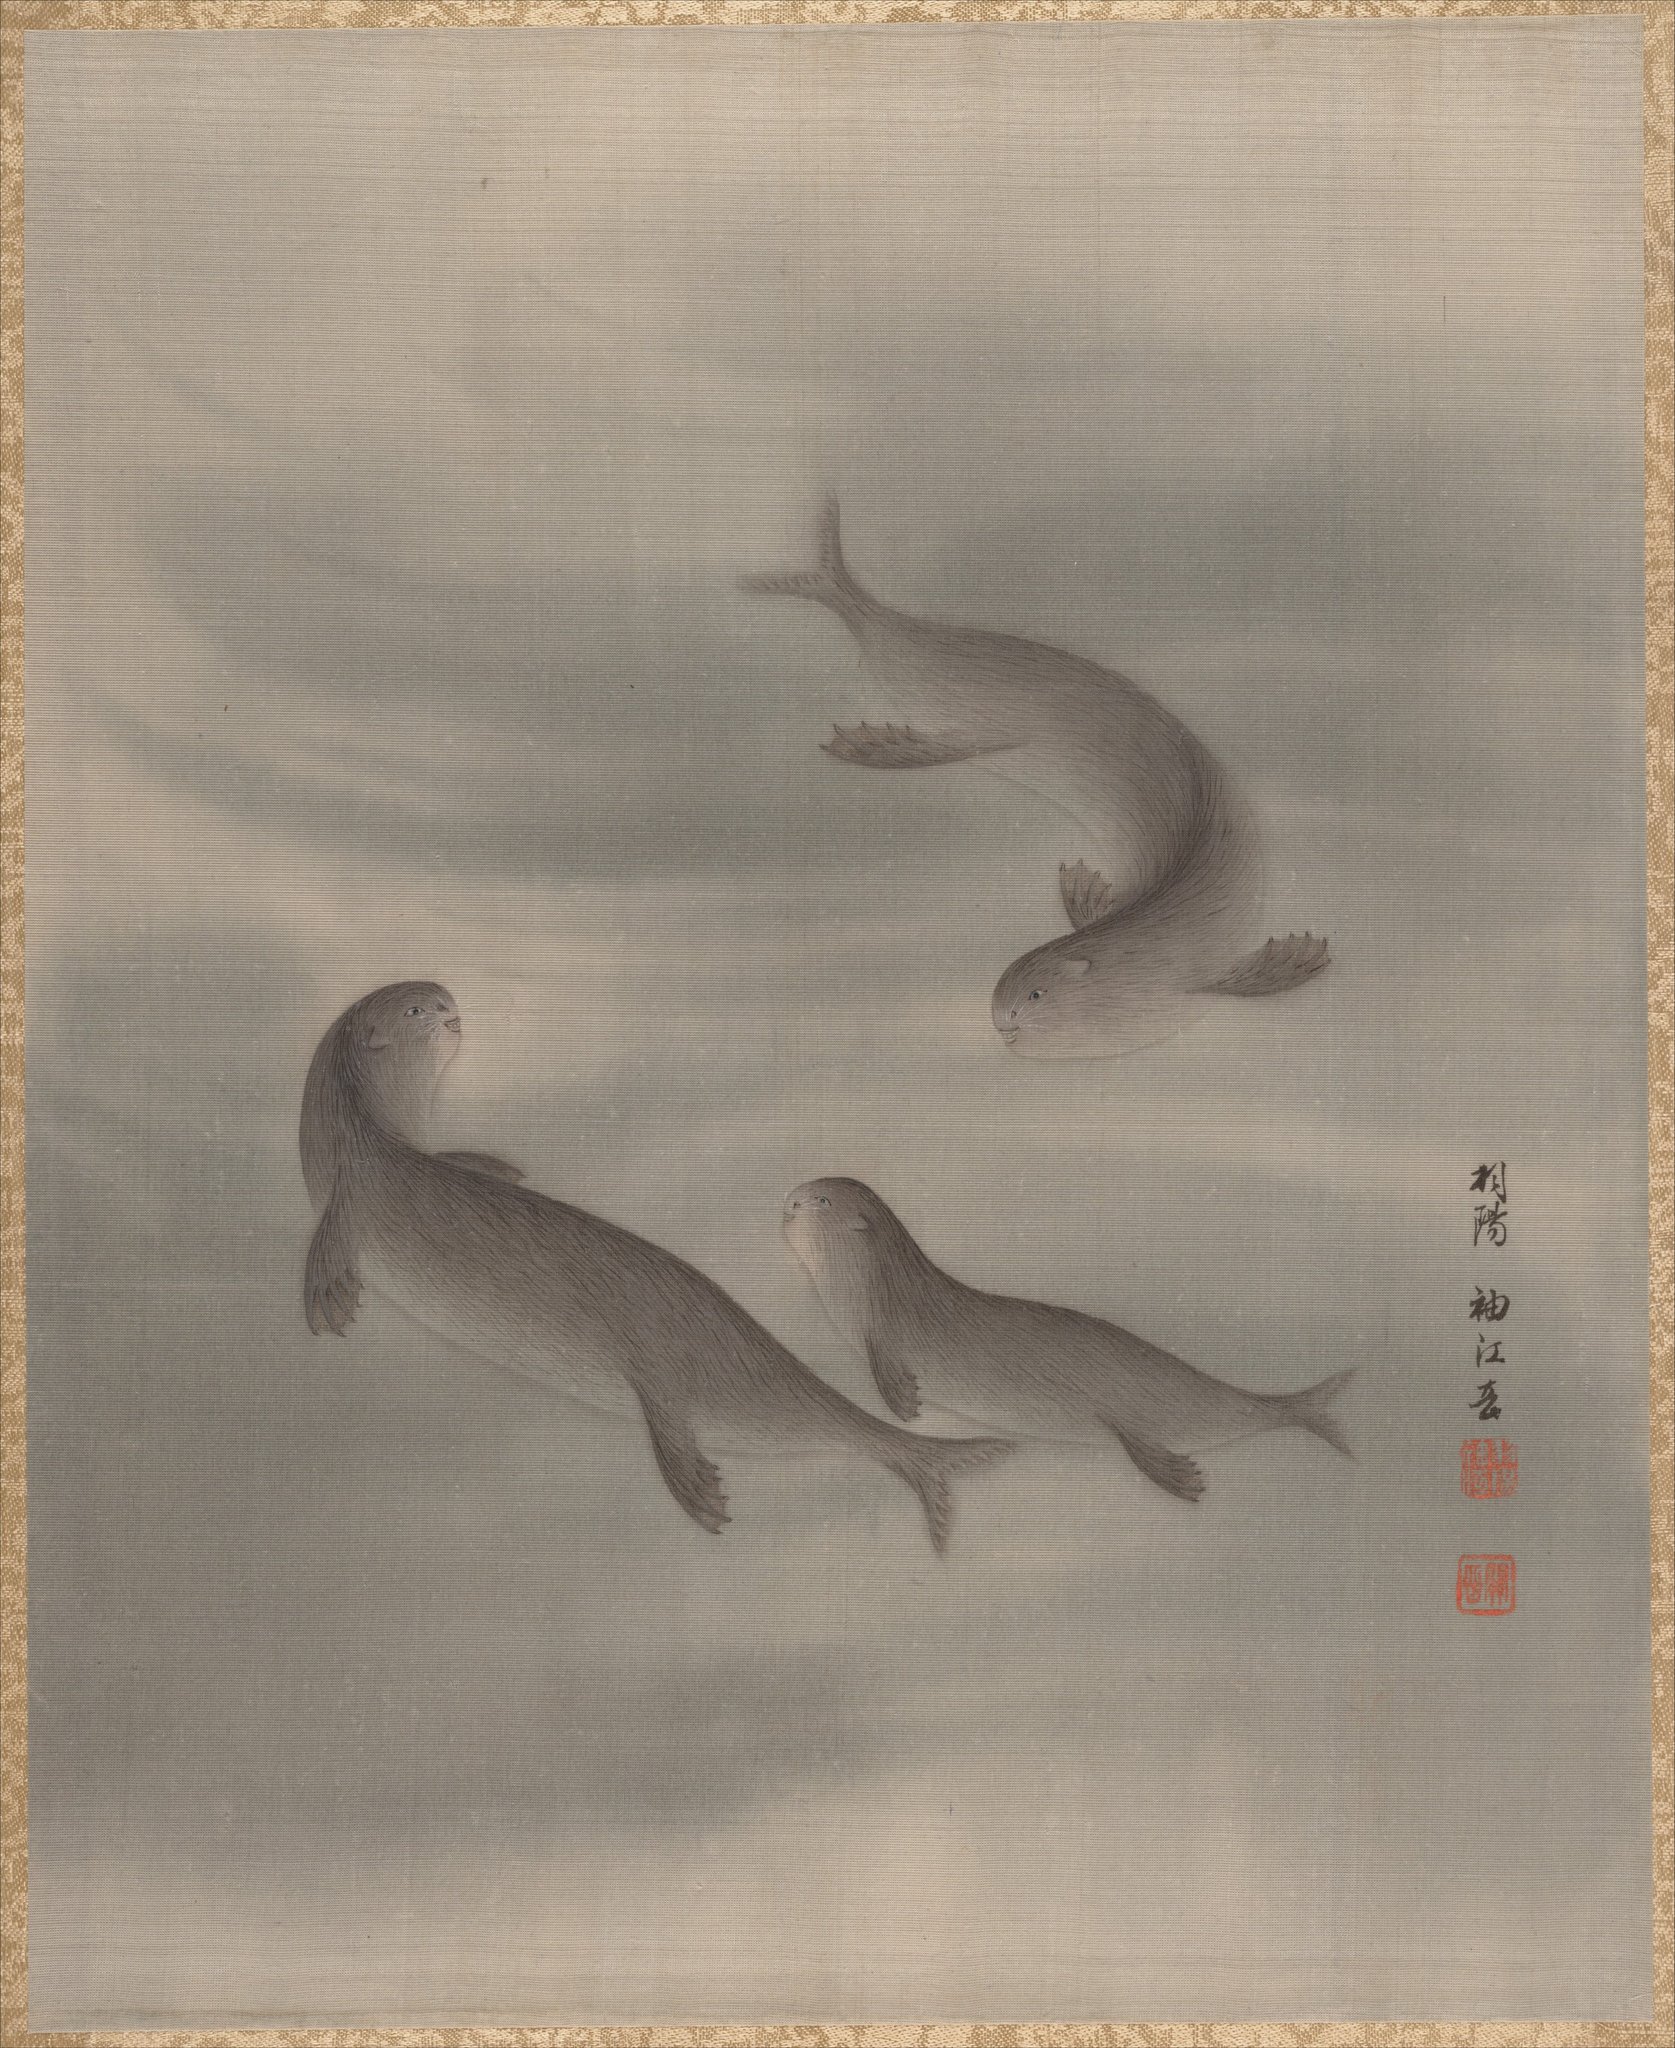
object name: album leaf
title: Otters Swimming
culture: japanese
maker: seki shūkō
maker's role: artist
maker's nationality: japanese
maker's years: 1858-1915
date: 1890-1892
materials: silk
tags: animals